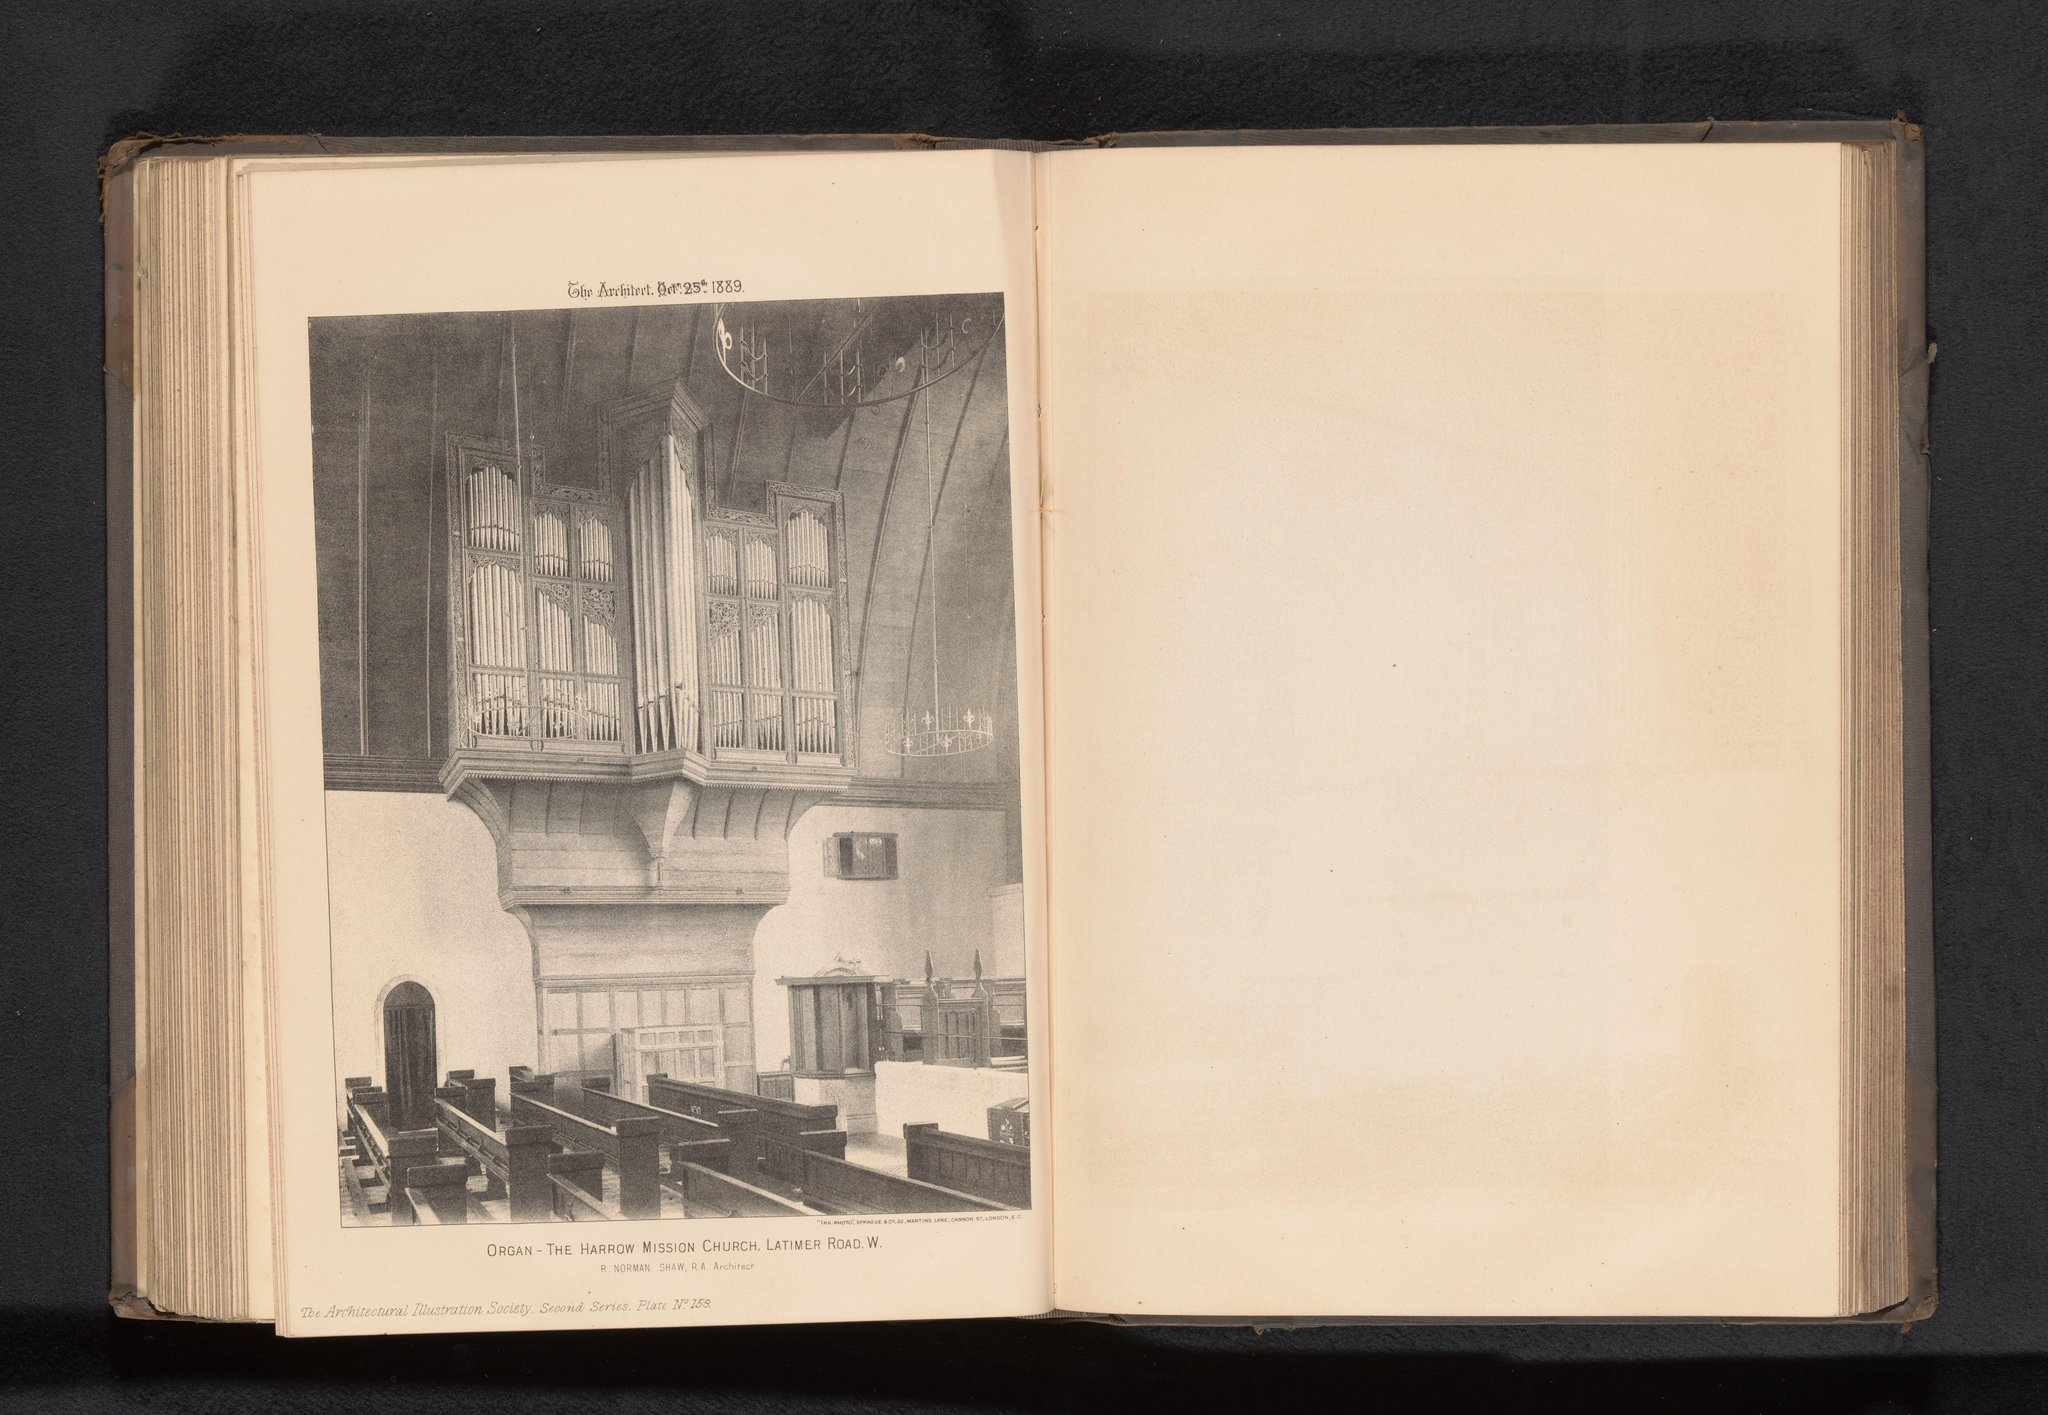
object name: page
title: Organ, The Harrow Mission Church, Latimer Road, W.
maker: Anonymous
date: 1884-1889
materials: paper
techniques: photolithography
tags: church organ, interior of church, london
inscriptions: inscription: ‘R. Norman Shaw, R.A. Architect/ The Architectural Illustration Society. Second Series. Plate No.158’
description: Prent op zesde ongenummerde pagina na pagina 238.